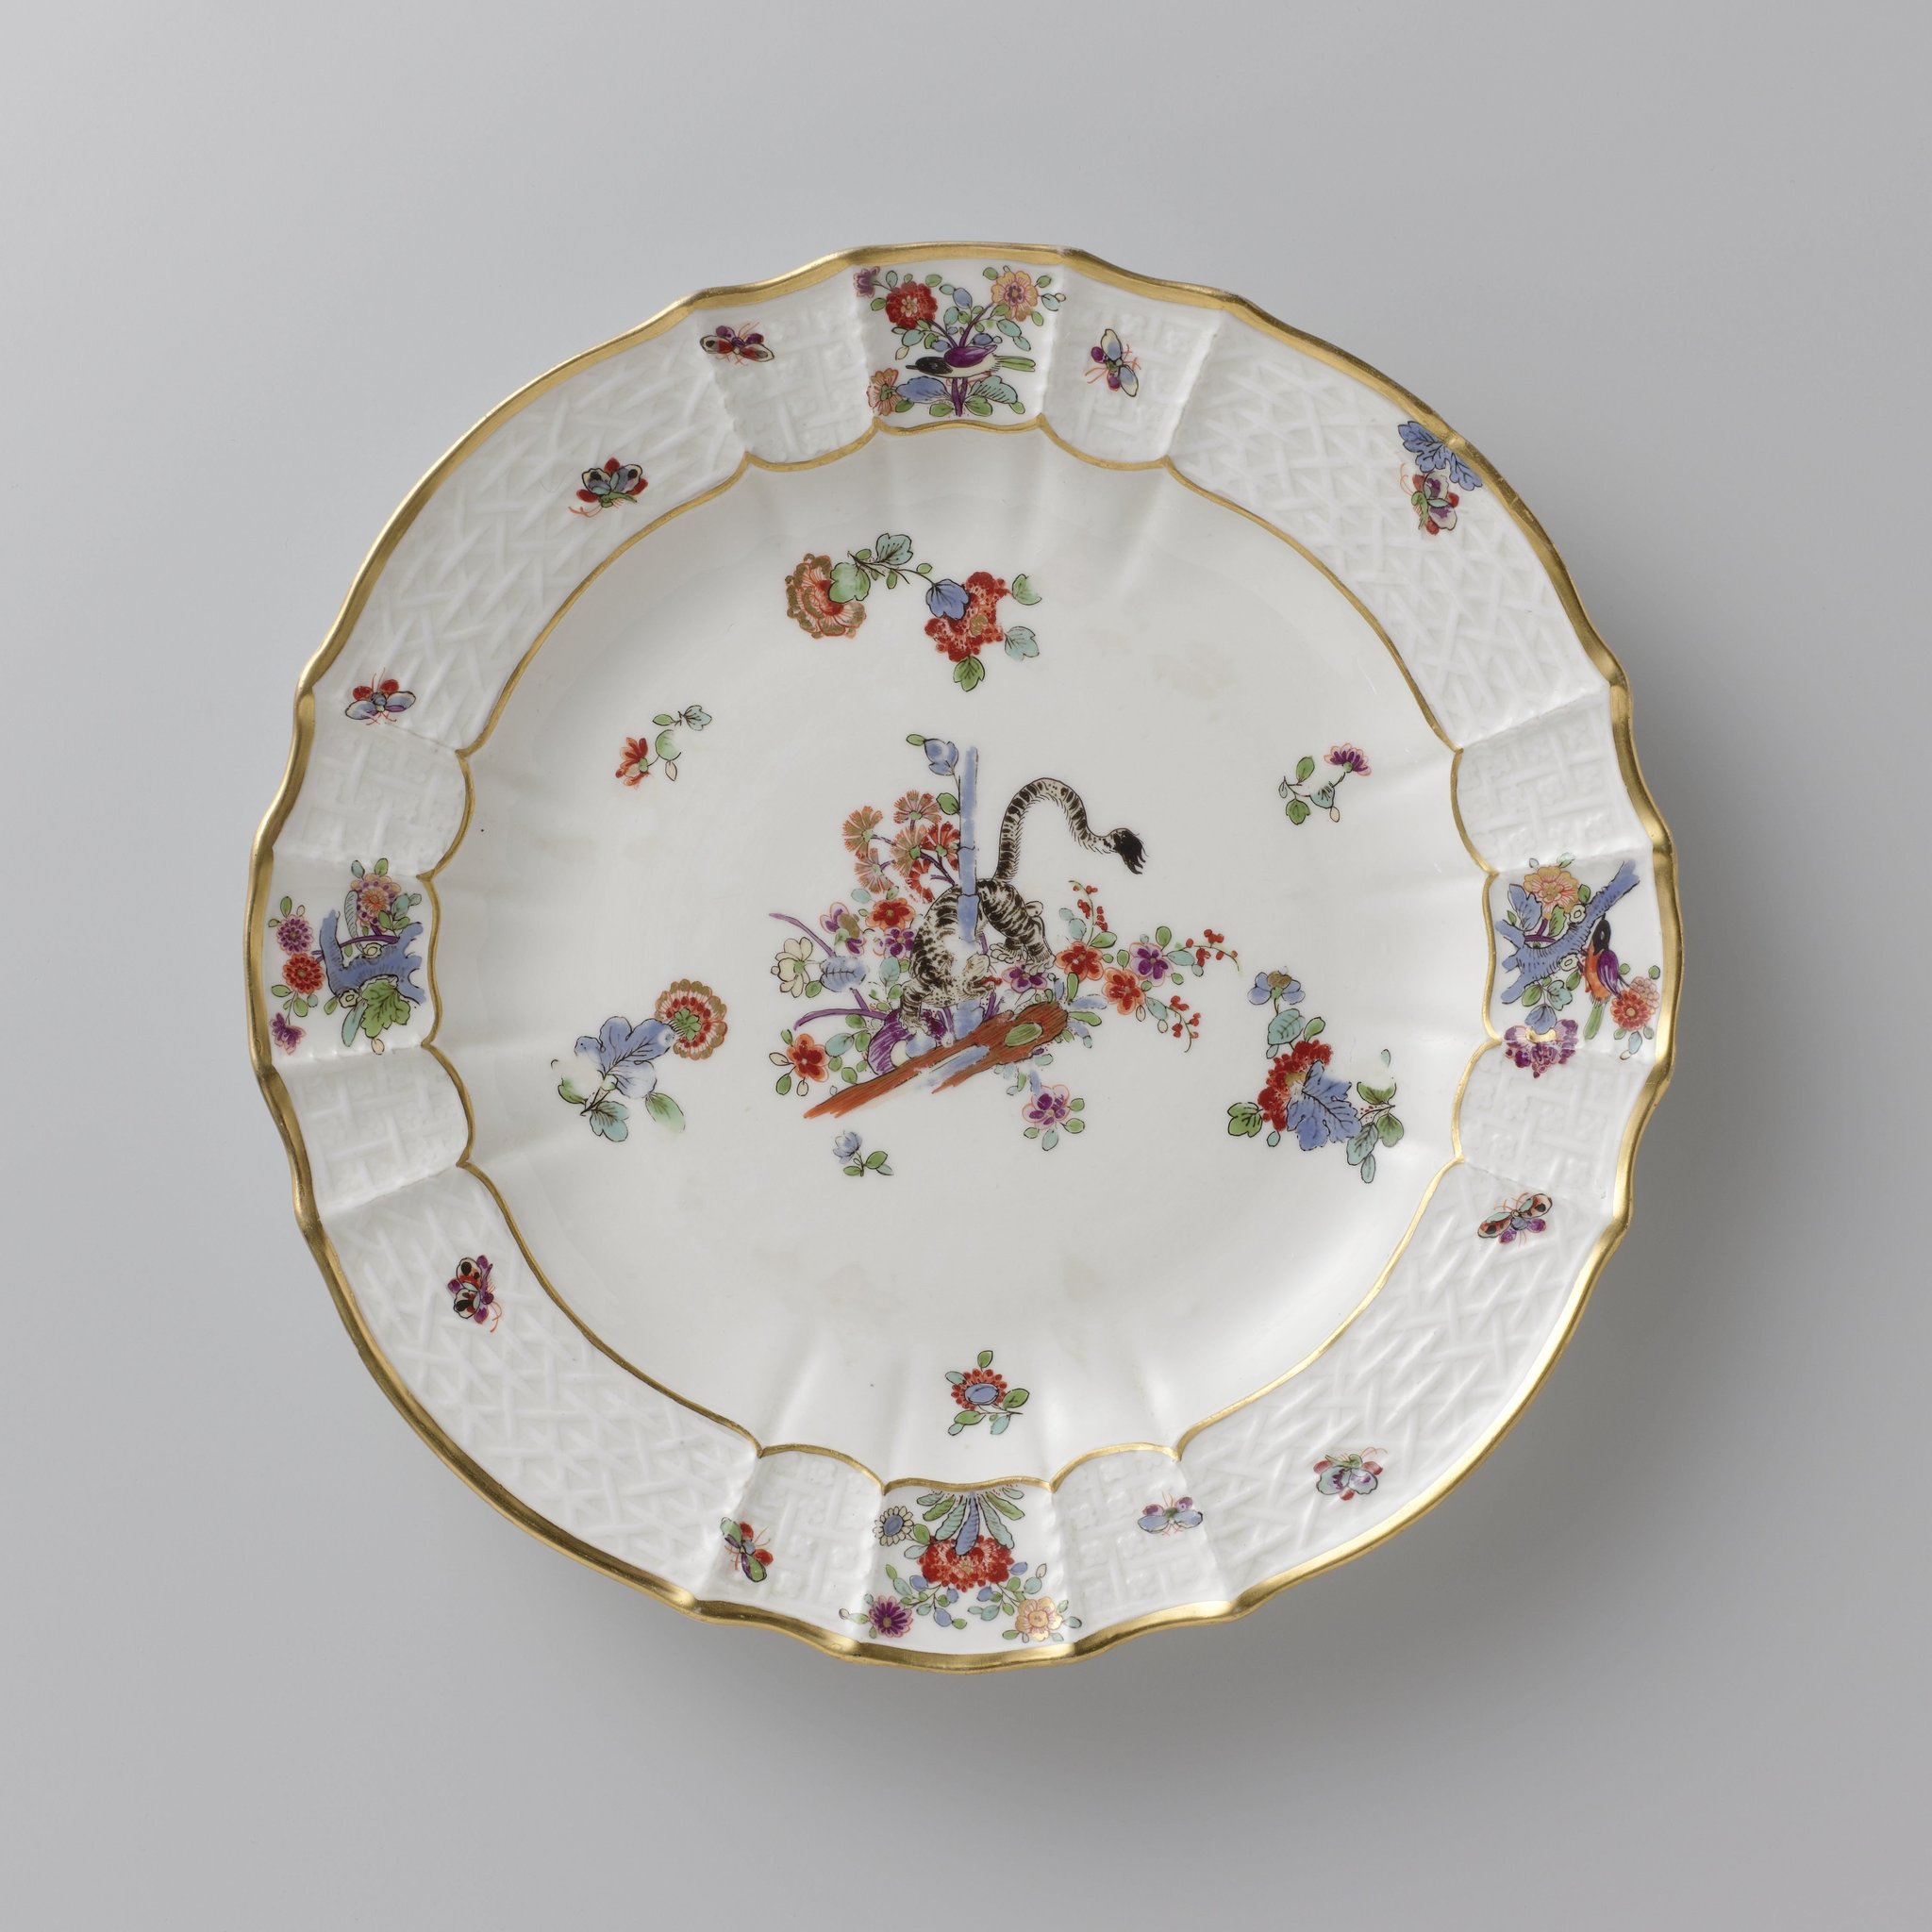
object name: plate dish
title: Rond bord, veelkleurig beschilderd met een Kakiemon-decor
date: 1740-1745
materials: porcelain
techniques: painted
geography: meissen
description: Rond bord van beschilderd porselein. Het bord is geribd en heeft een geschulpte rand. Het bord is beschilderd met een tijger die om een blauwe bamboestengel tussen bloemen is gedraaid, gestrooide Indianische Blumen, vlinders en takken waarop vogels. De rand is versierd met het 'Altbrandenstein'-patroon. Het bord is gemerkt.